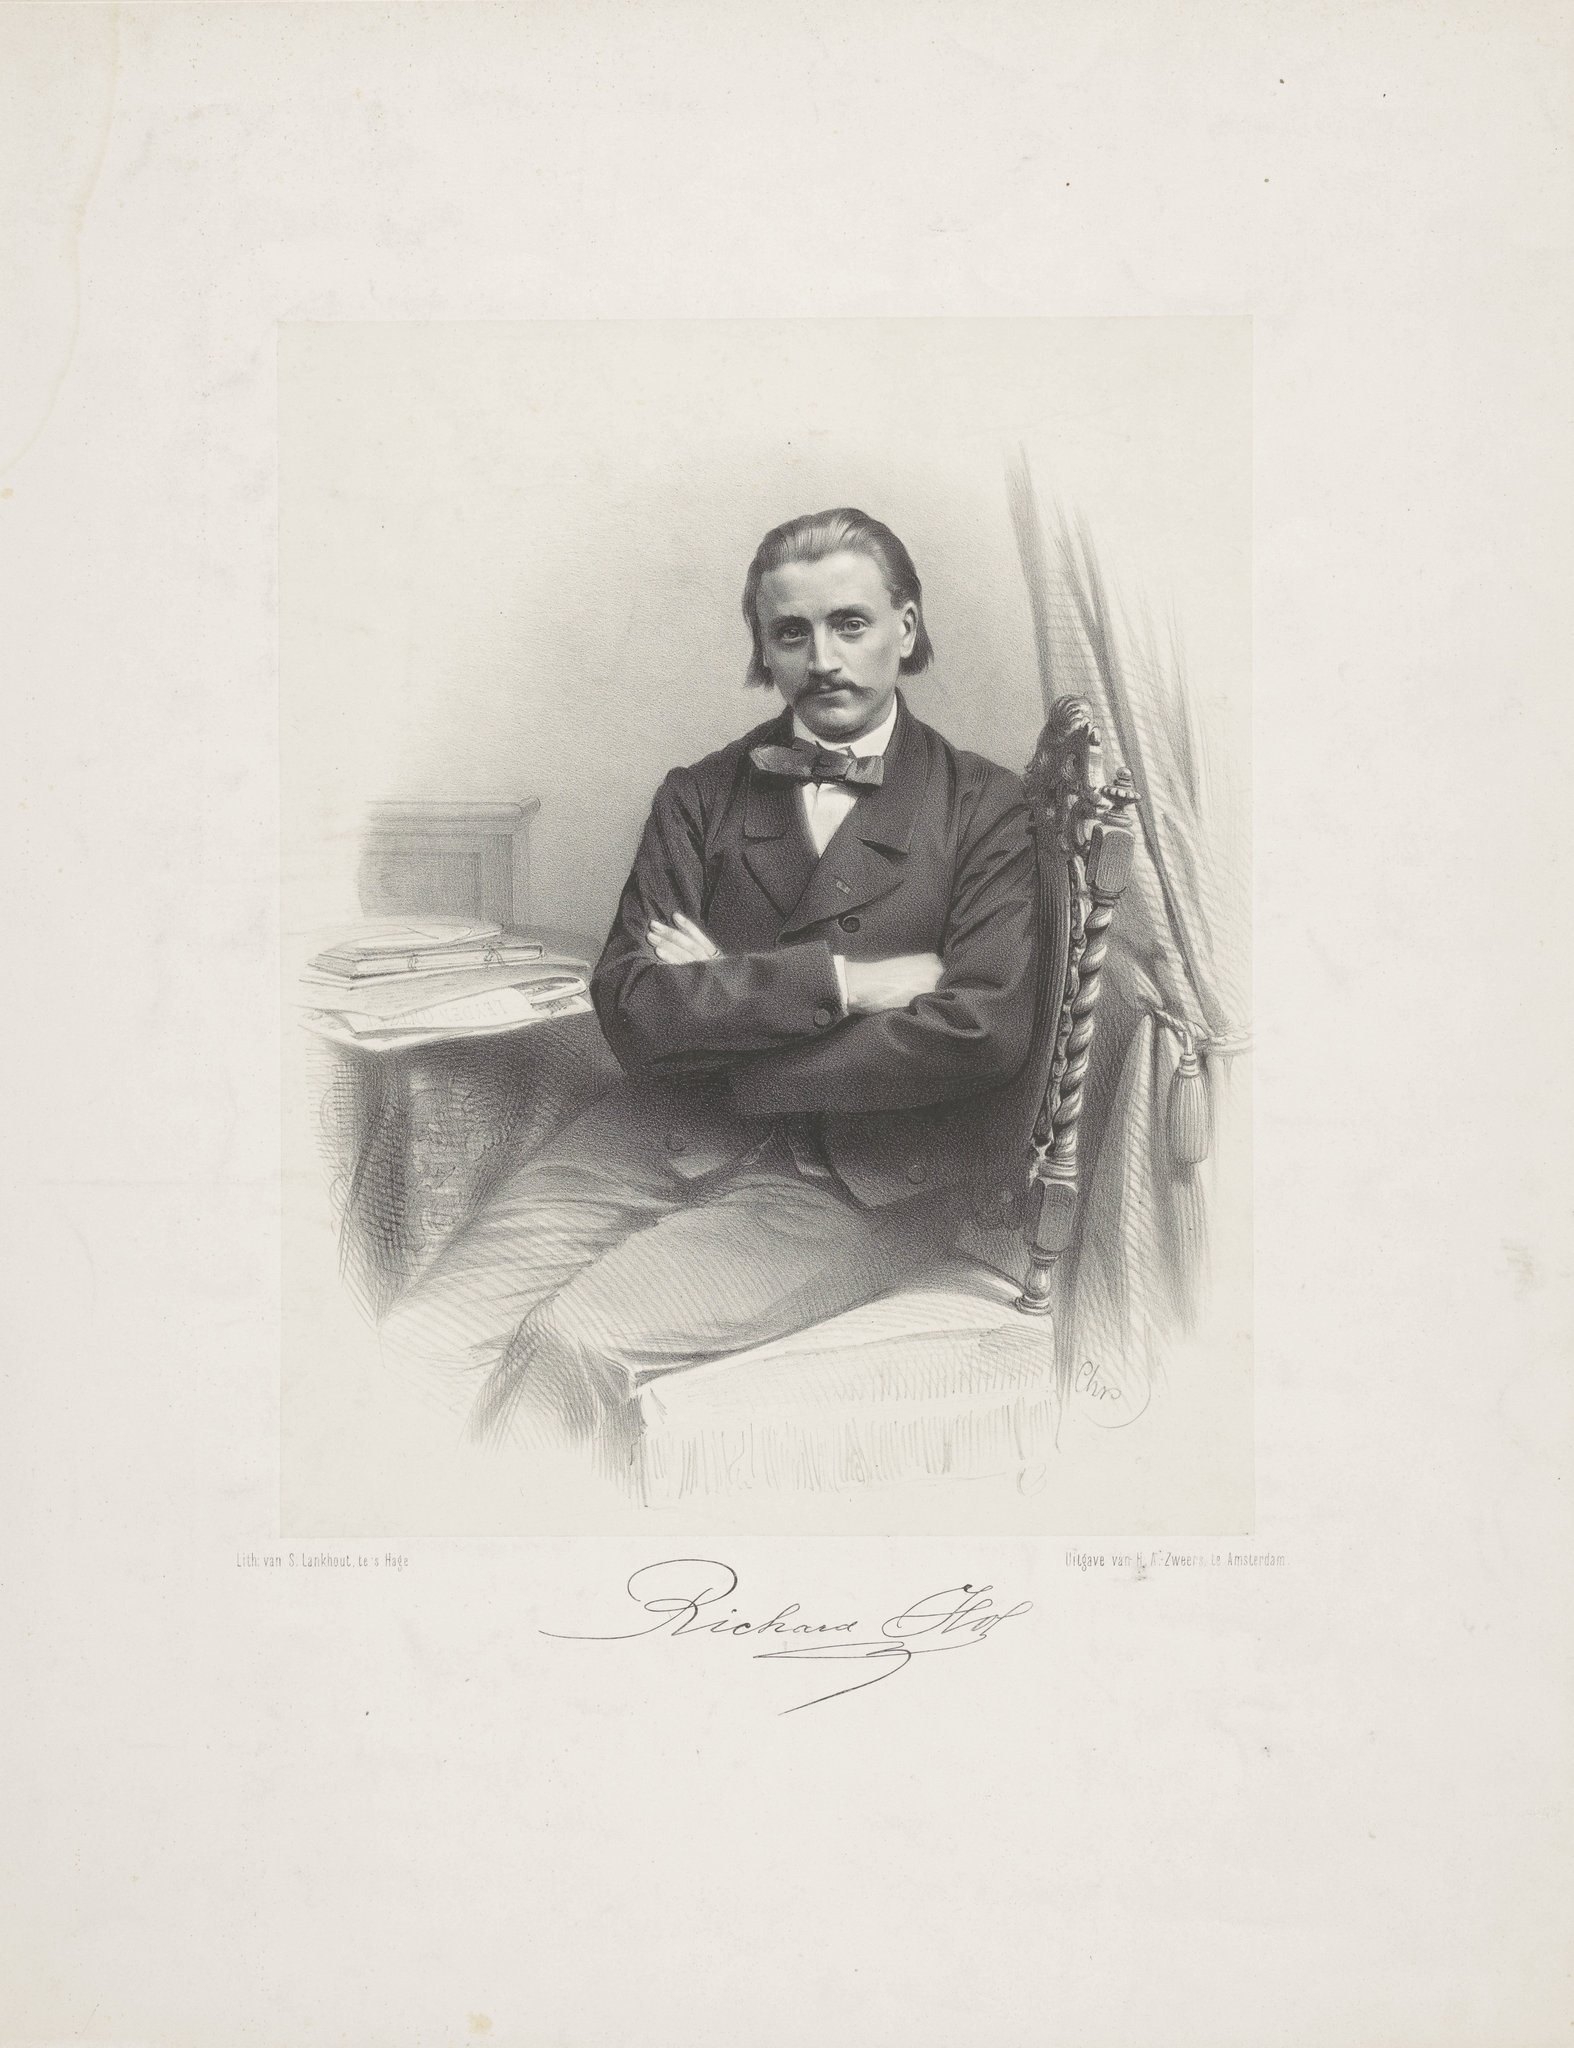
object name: print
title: Portret van Richard Hol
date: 1856-1867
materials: paper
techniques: lithograph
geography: amsterdam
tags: amsterdam, artist, printed edition of musical score, historical persons (+ three-quarter length portrait)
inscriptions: collector's mark: Lugt 2228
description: De geportretteerde zit met zijn armen over elkaar op een stoel. Hij heeft zijn haar achterover gekamd en draagt een snor. Op de tafel naast hem liggen papieren met notenschrift en een blad met de titel: 'Leyden Ontzet'.